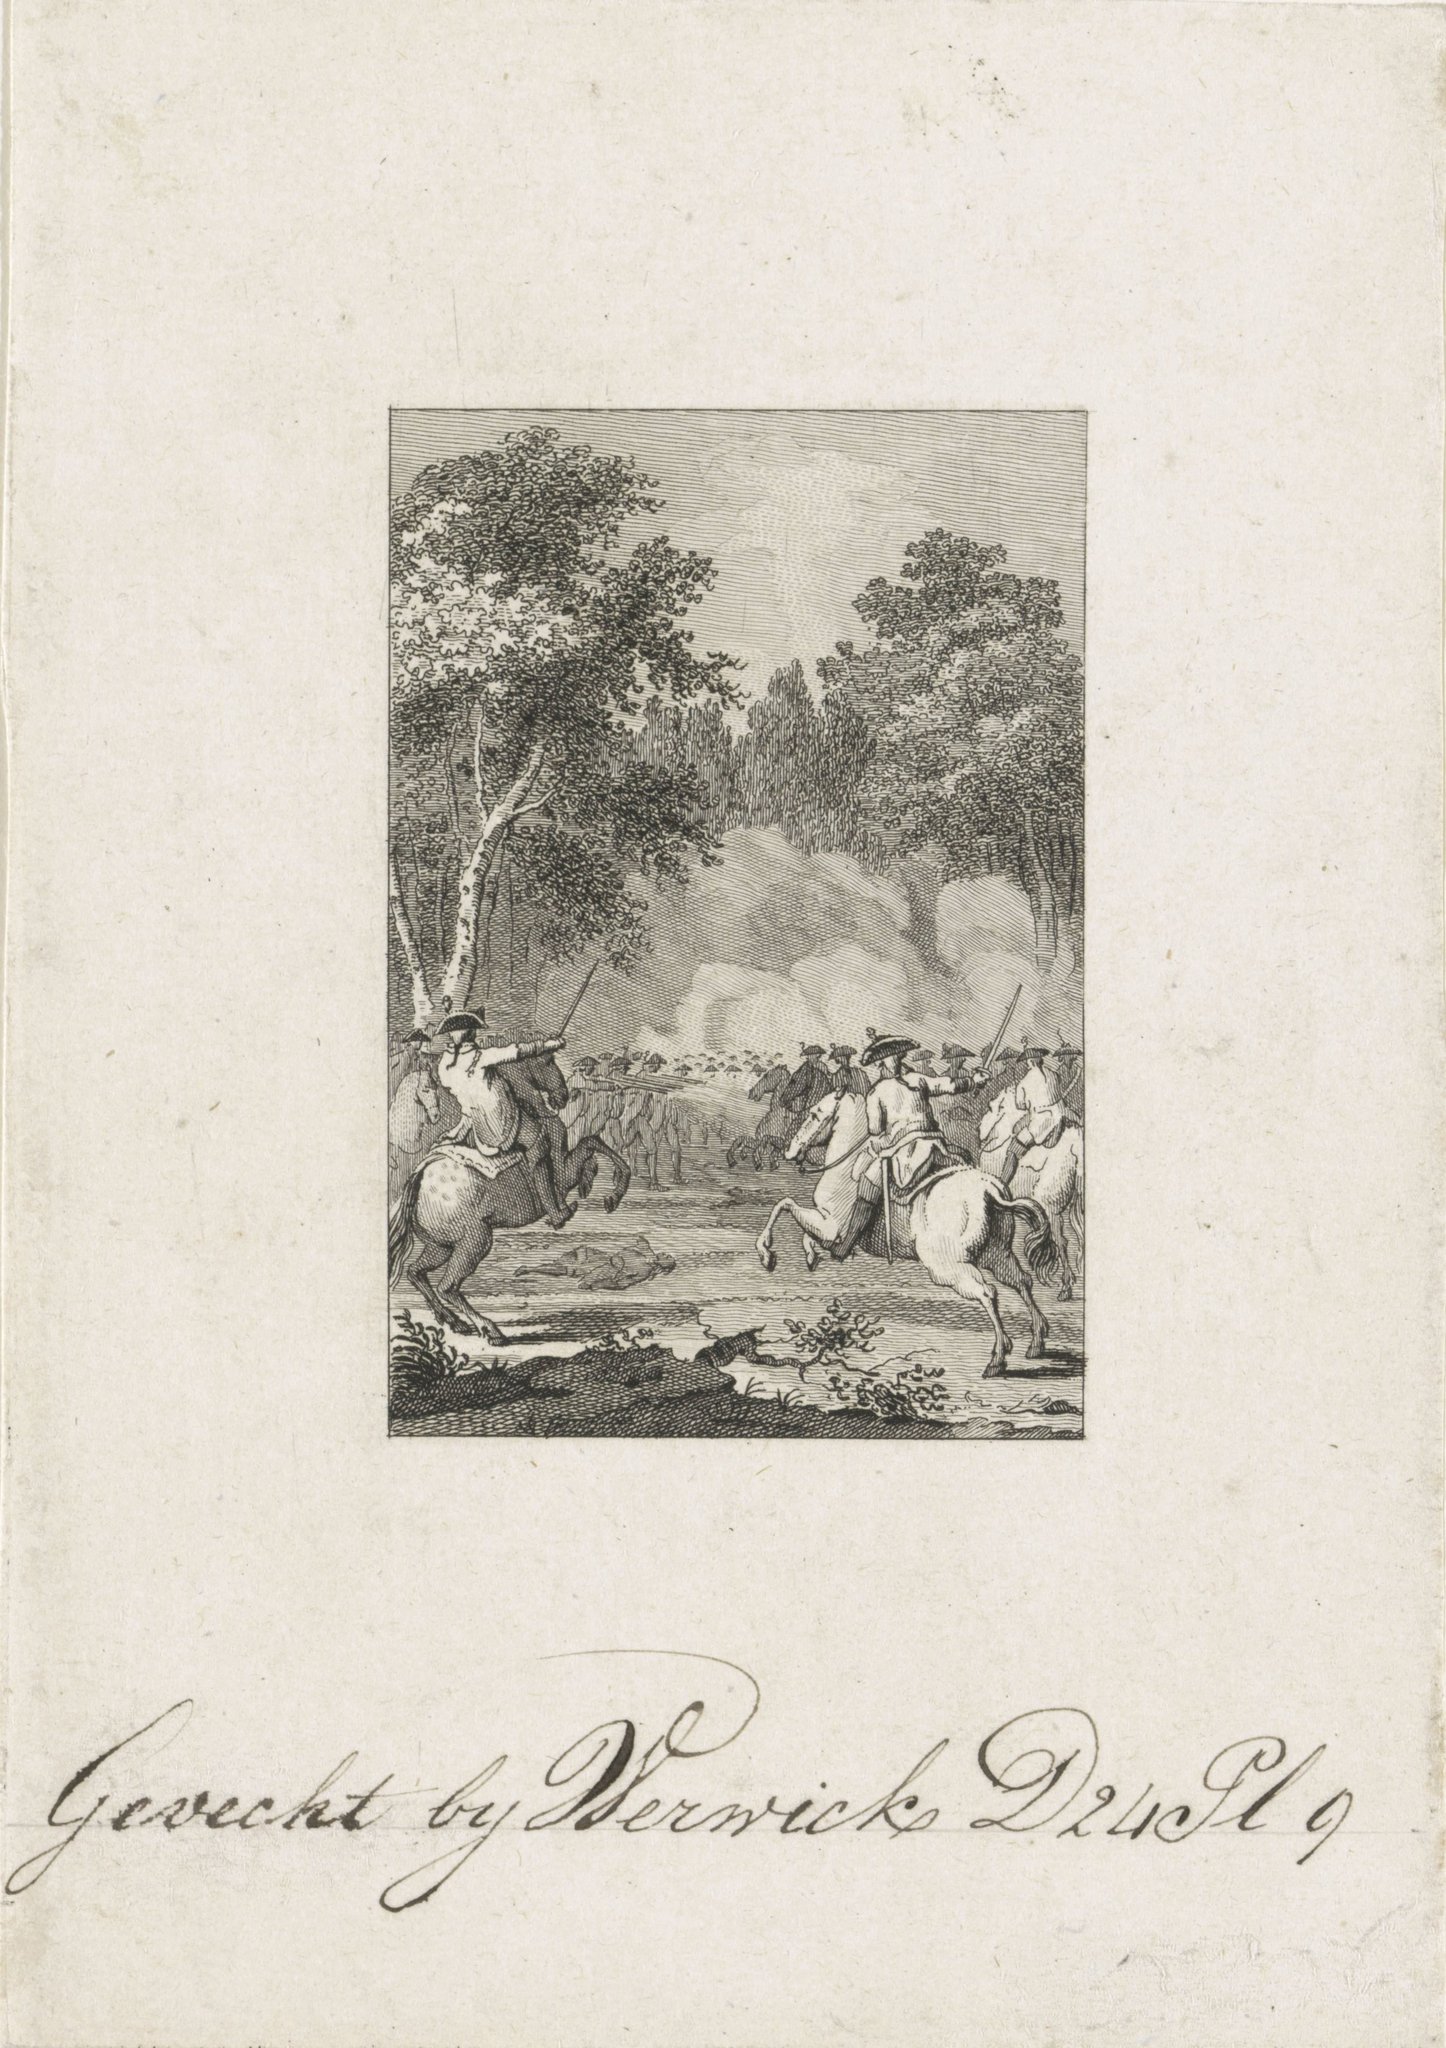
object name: print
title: Slag bij Wervik en het gewond raken van de prins, 1793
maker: cornelis bogerts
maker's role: print maker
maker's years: 1745-1817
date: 1793-1795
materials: paper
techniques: engraving, etching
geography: northern netherlands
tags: the hague, willem george frederik (prins van oranje-nassau), battle (+ land forces)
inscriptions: collector's mark: Lugt 2228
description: Veldslag tussen Coalitietroepen en het Franse revolutionaire leger bij Wervik in West-Vlaanderen op 13 september 1793 waarbij Willem George Frederik, prins van Oranje-Nassau, gewond raakt. Met titel in handgeschreven opschrift.